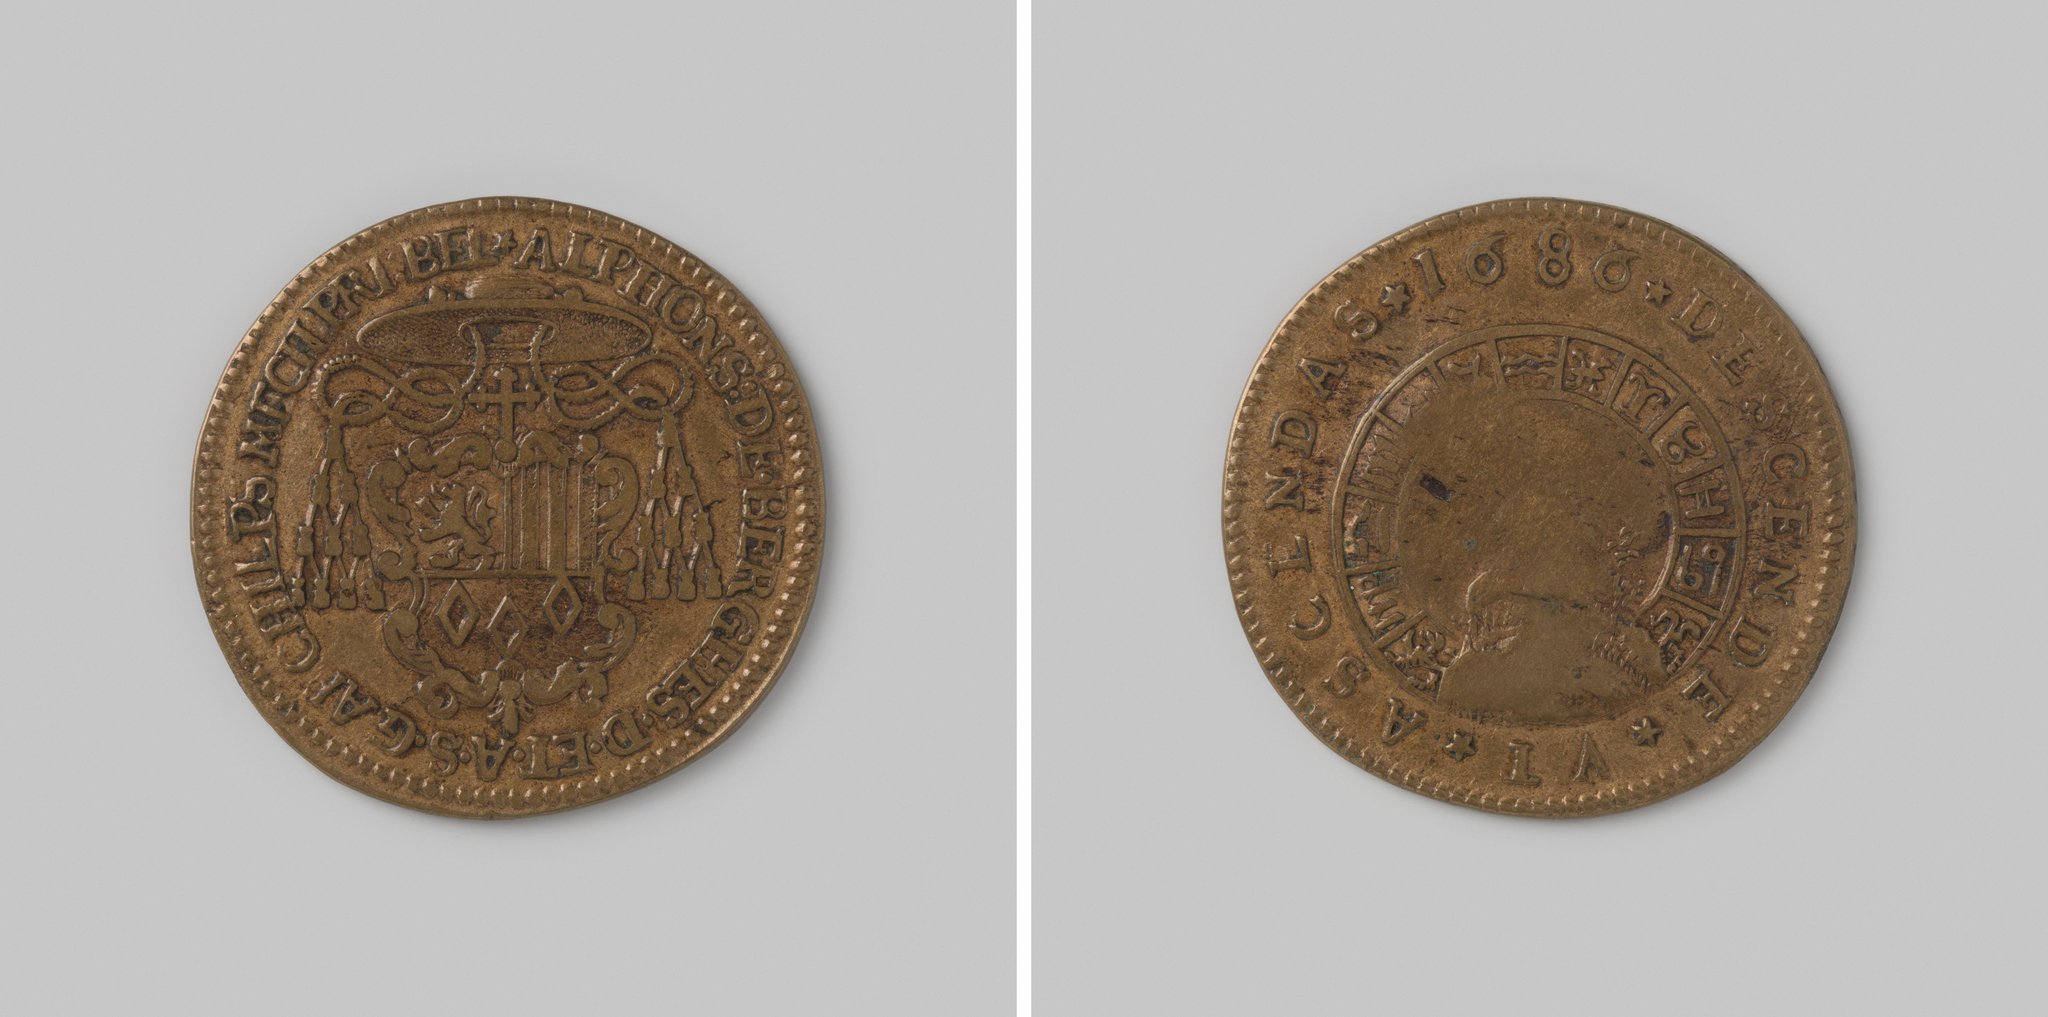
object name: jeton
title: Rekenpenning voor Alphons van Bergen Aartsbisschop van Mechelen 1686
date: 1686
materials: brass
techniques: striking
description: Messing penning, op de voorzijde een wapenschild onder een kardinaalshoed, met omschrift, op de keerzijde een berg in het midden van de dierenriem, met omschrift.